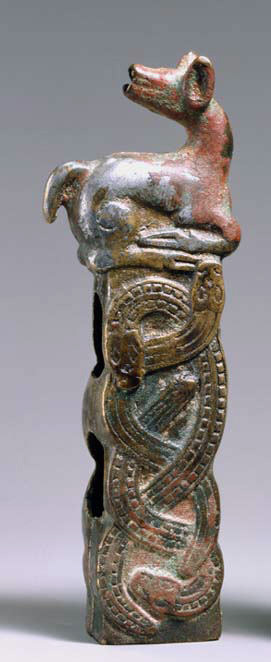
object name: fitting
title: Horse Fitting with Doe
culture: northwest chinese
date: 500-301 BCE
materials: bronze